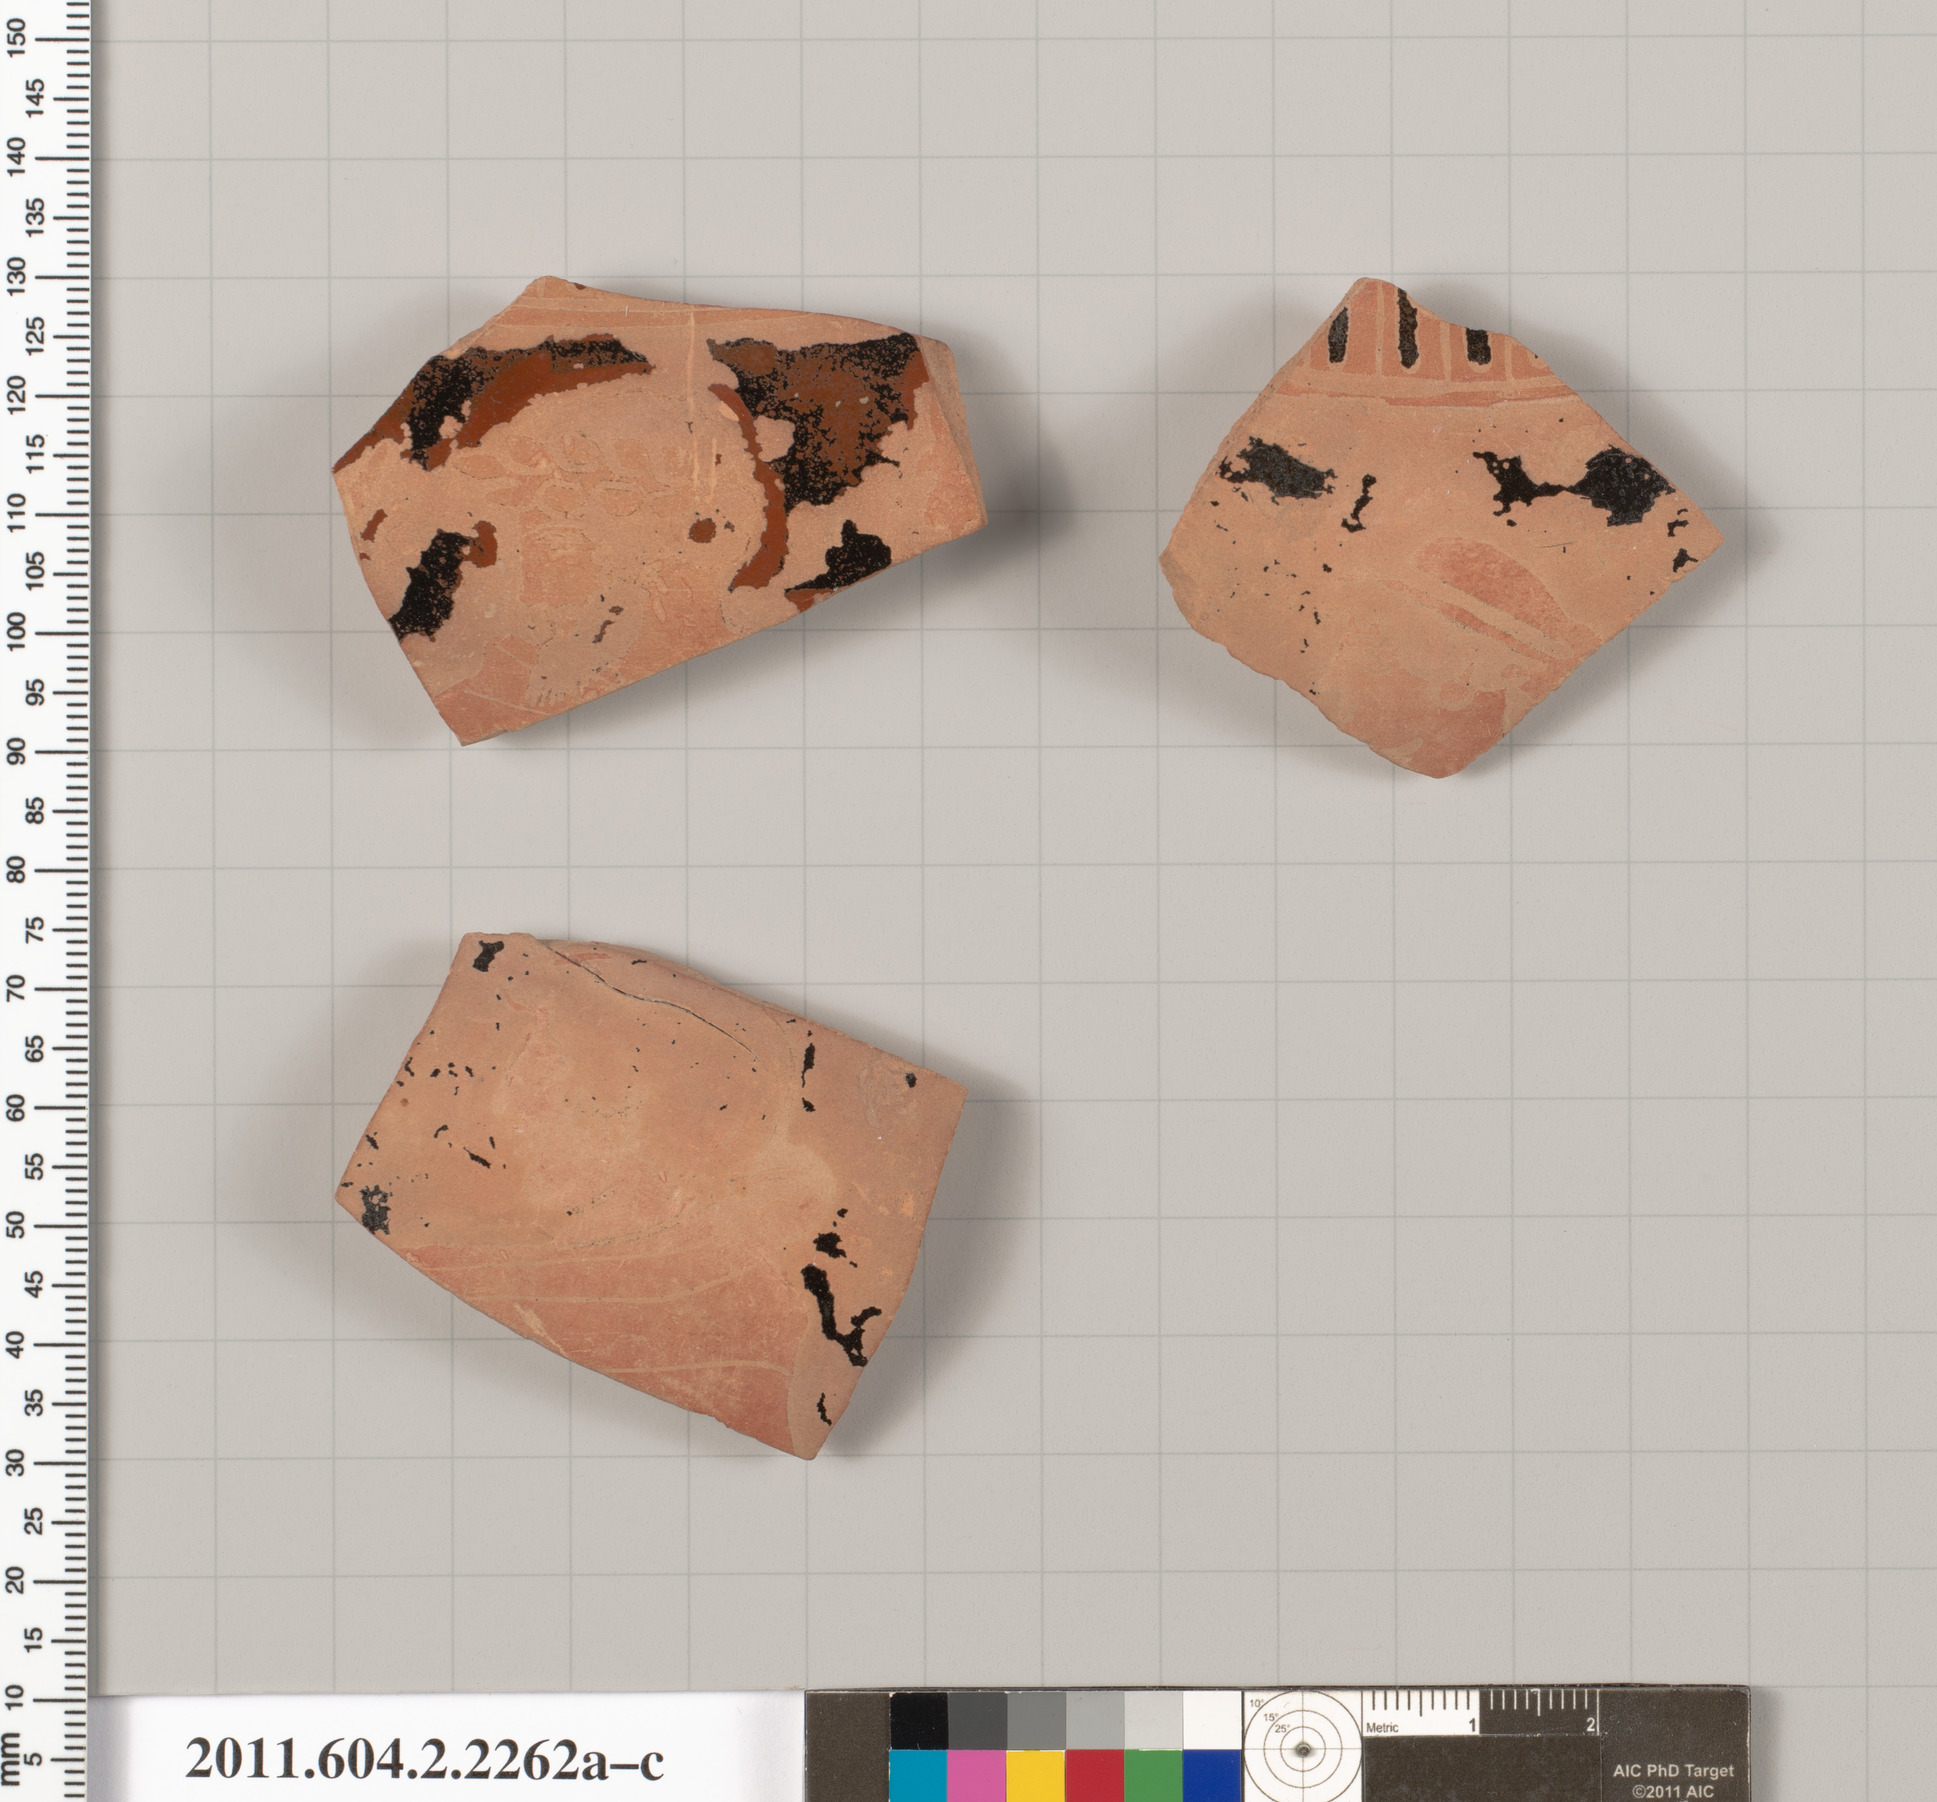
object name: pot fragment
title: Terracotta fragments of a pot; unglazed on the inside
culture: greek, attic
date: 460-440 BCE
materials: terracotta